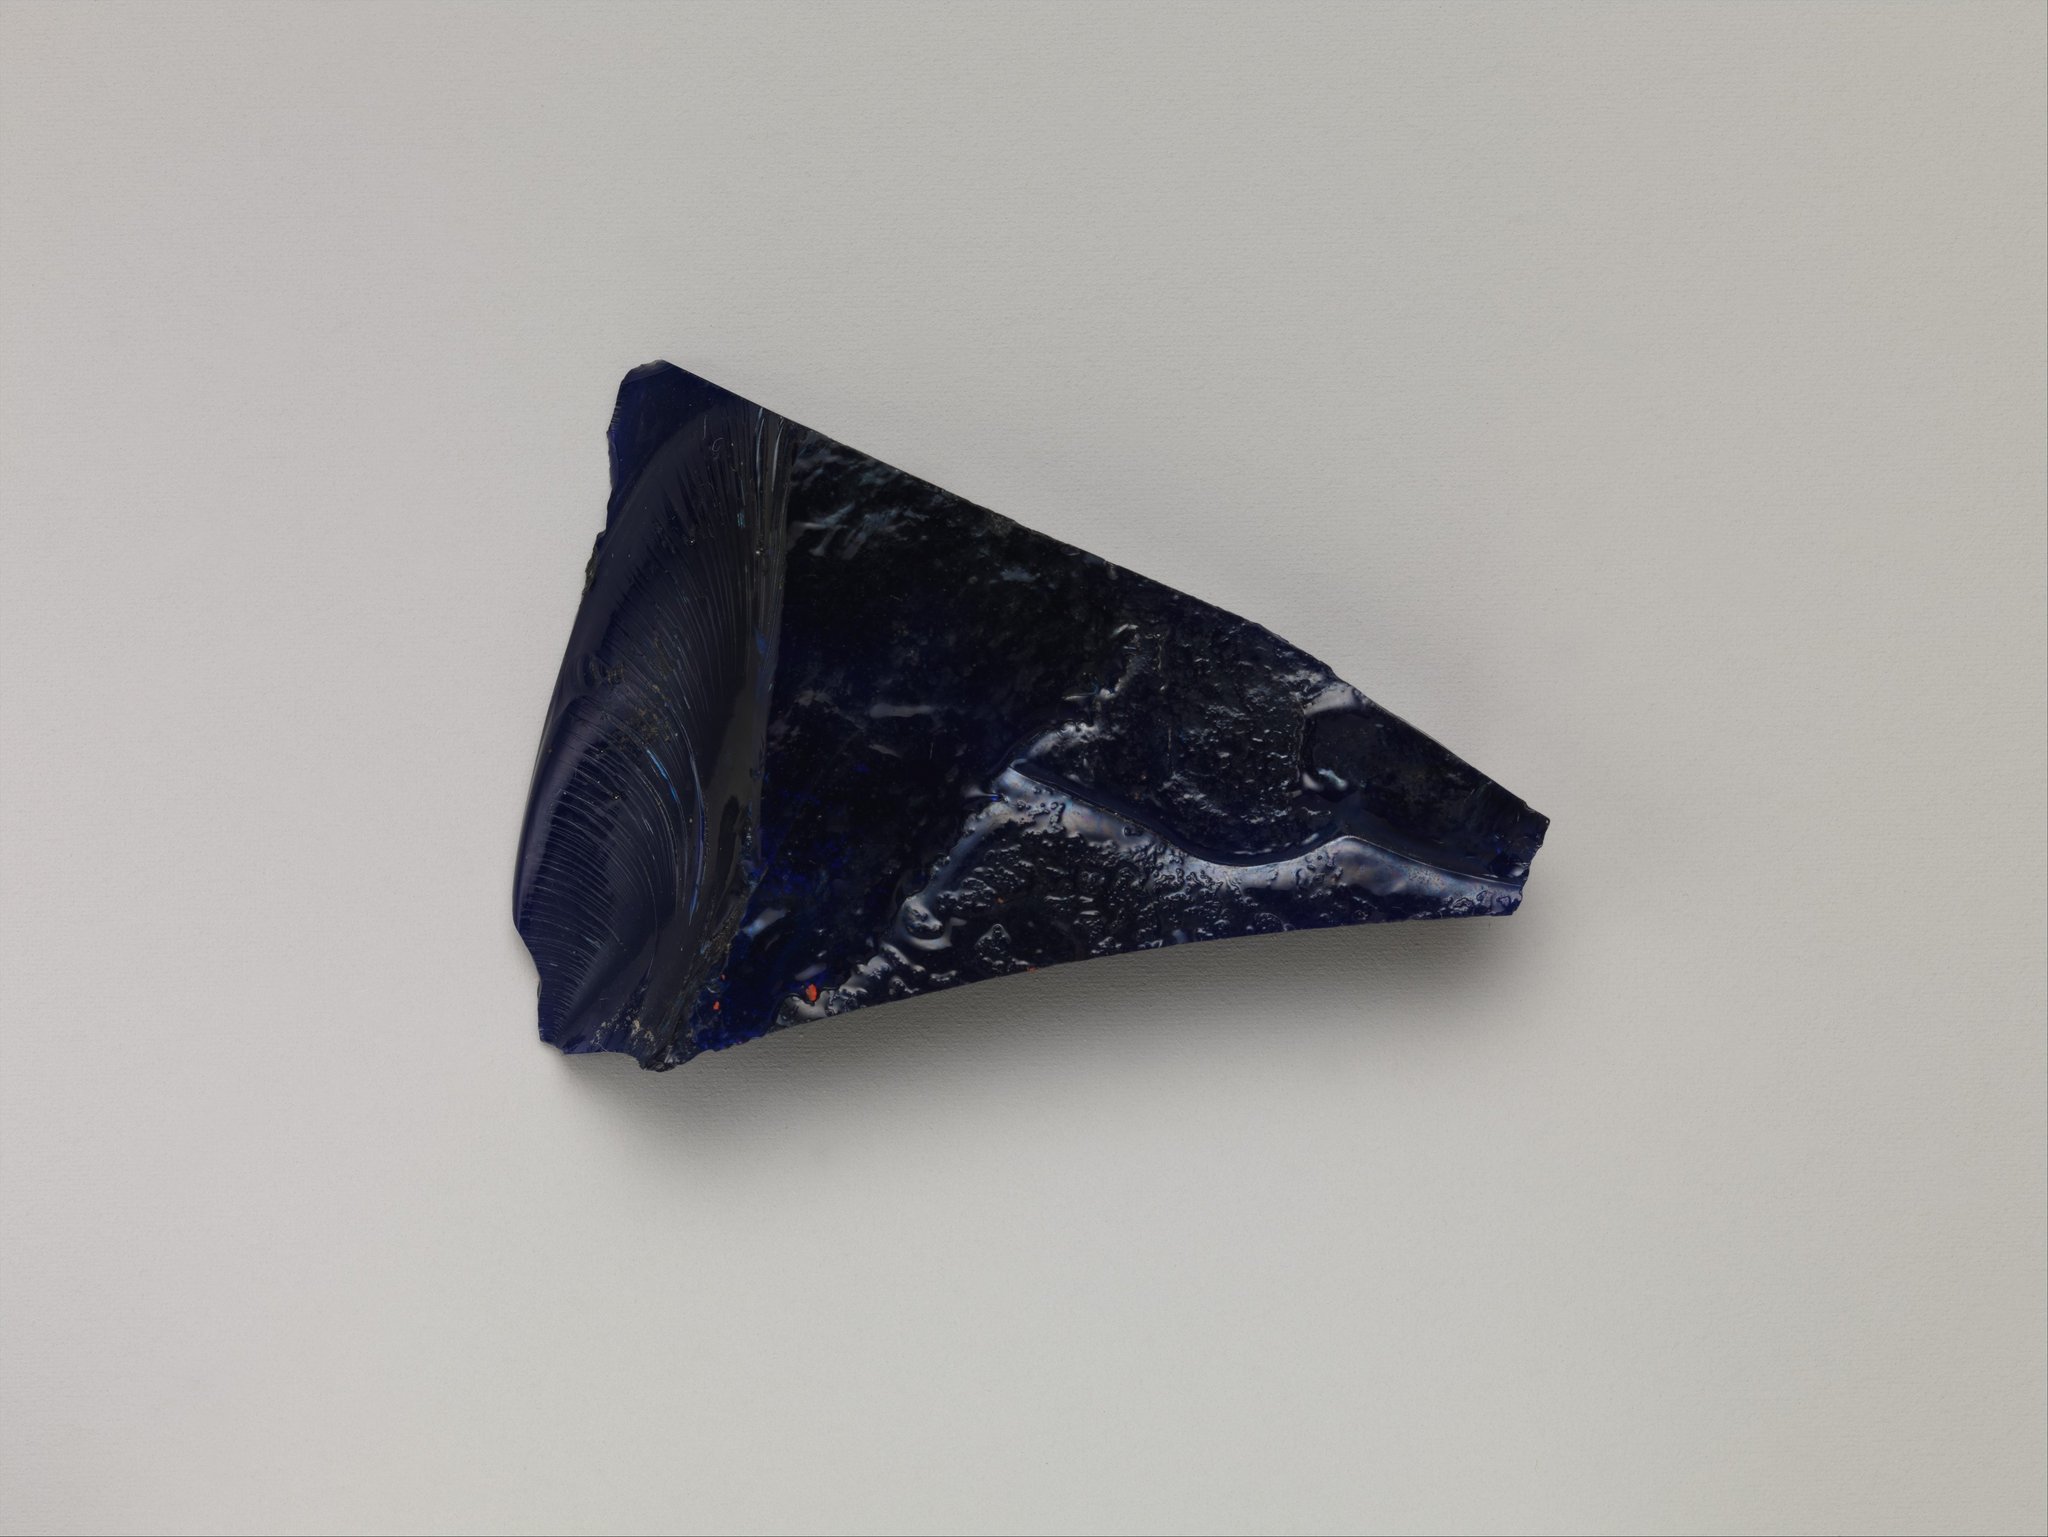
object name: fragment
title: Fragment from sample set of Chinese cloisonné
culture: chinese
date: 1867-1900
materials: copper alloy, enamel, glass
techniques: enamel